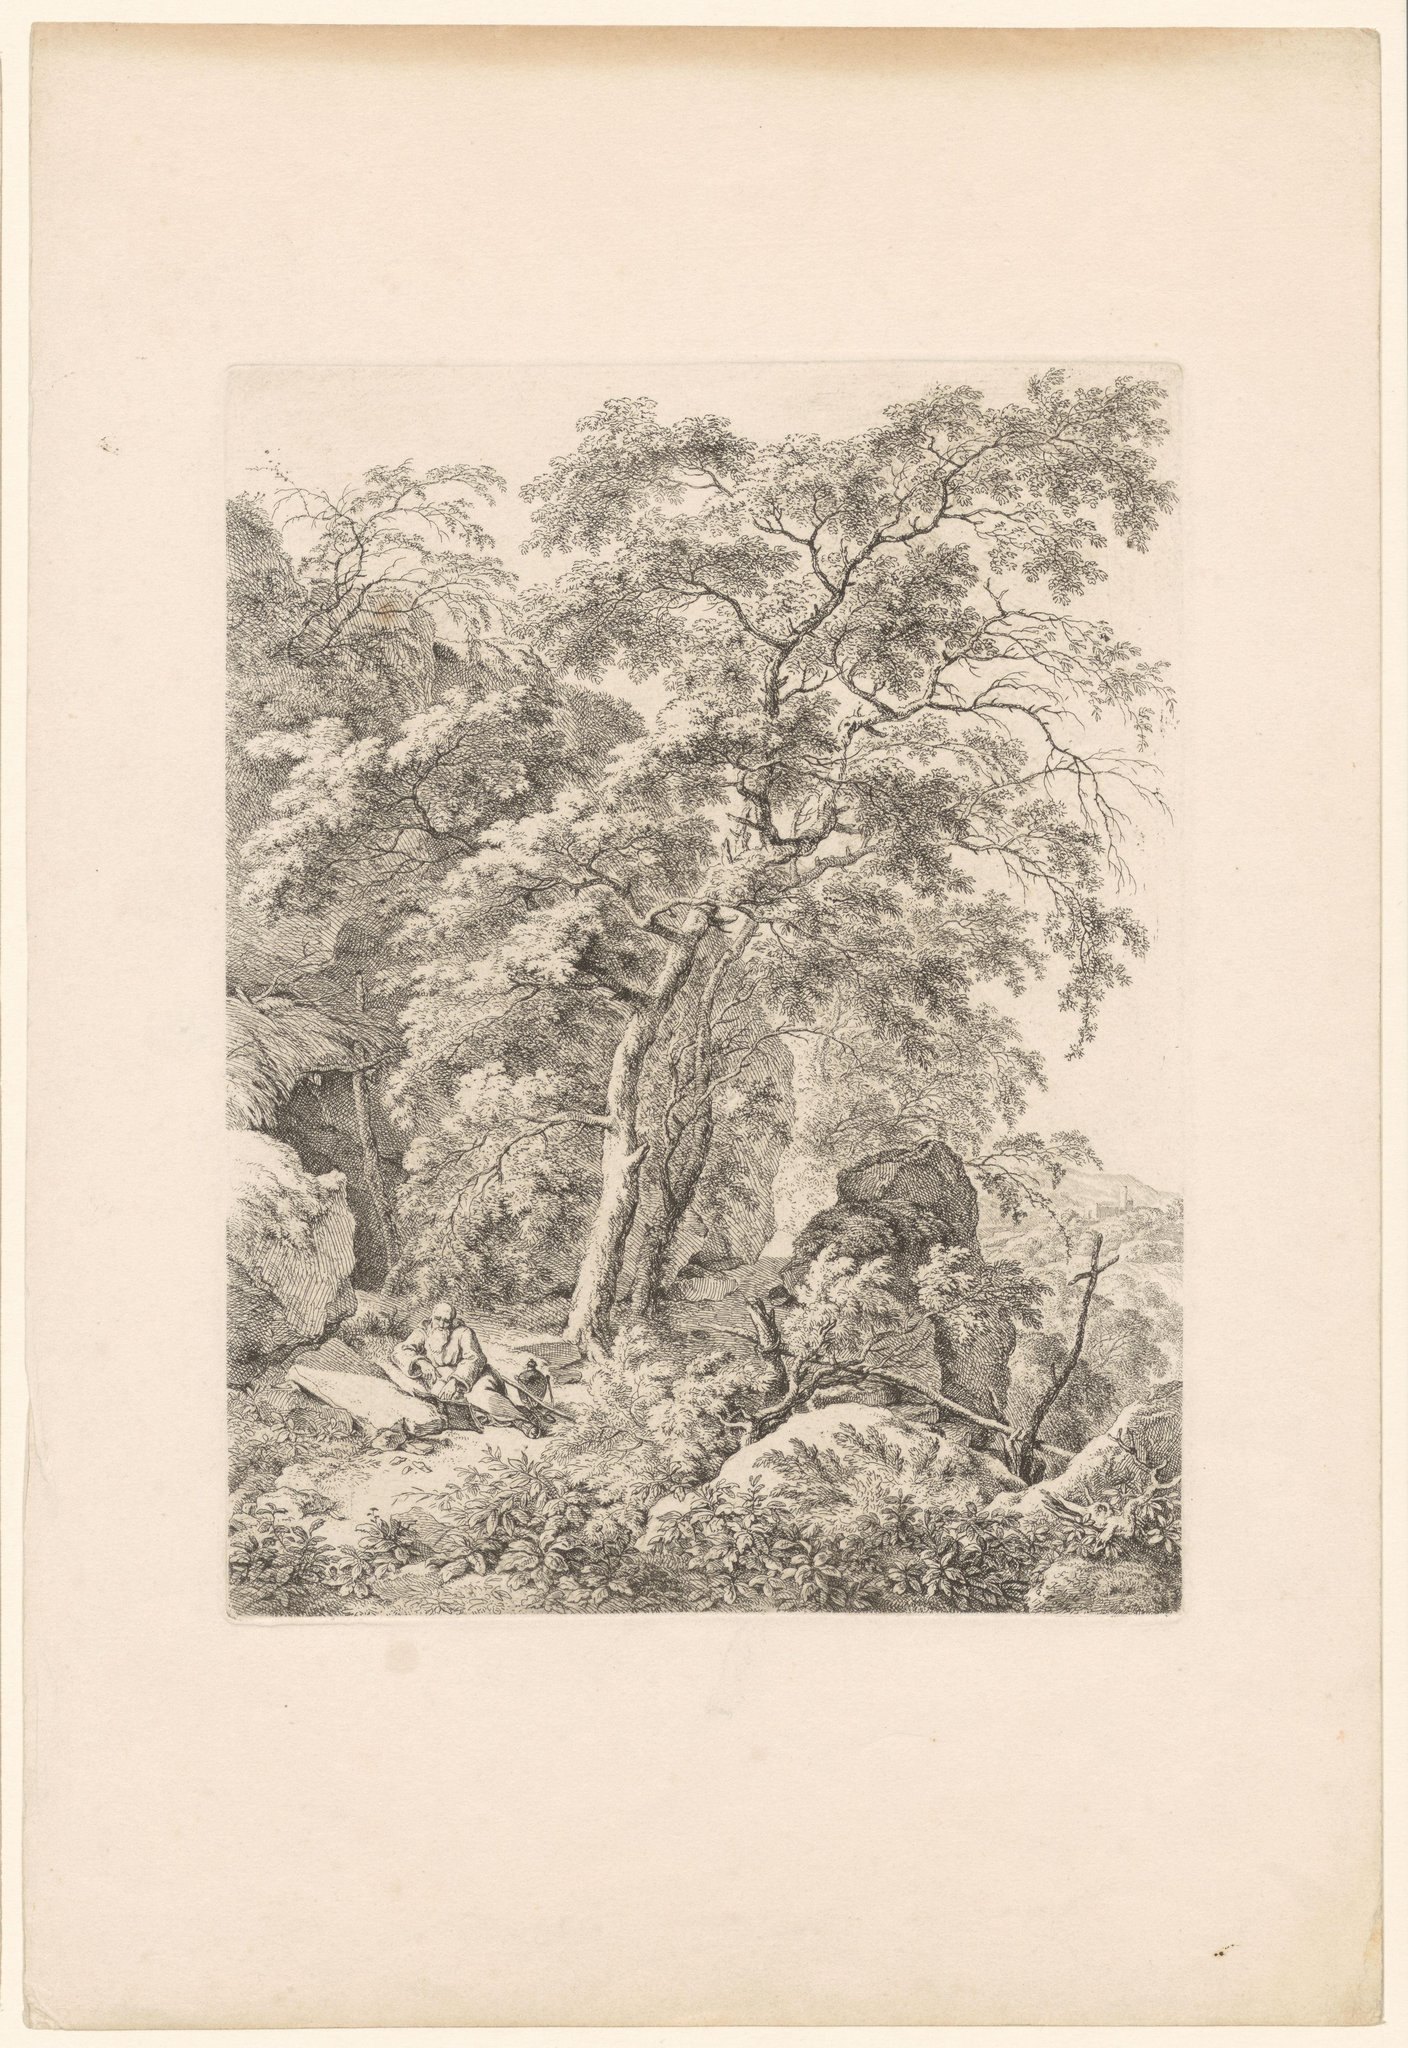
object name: print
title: Landschap met kluizenaar rustend bij een grote boom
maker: ferdinand kobell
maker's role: artist, painter, print maker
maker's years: 1740-1799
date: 1750-1799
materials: paper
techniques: etching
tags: (high) hill, anchorite, hermit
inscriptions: collector's mark: Lugt 2228